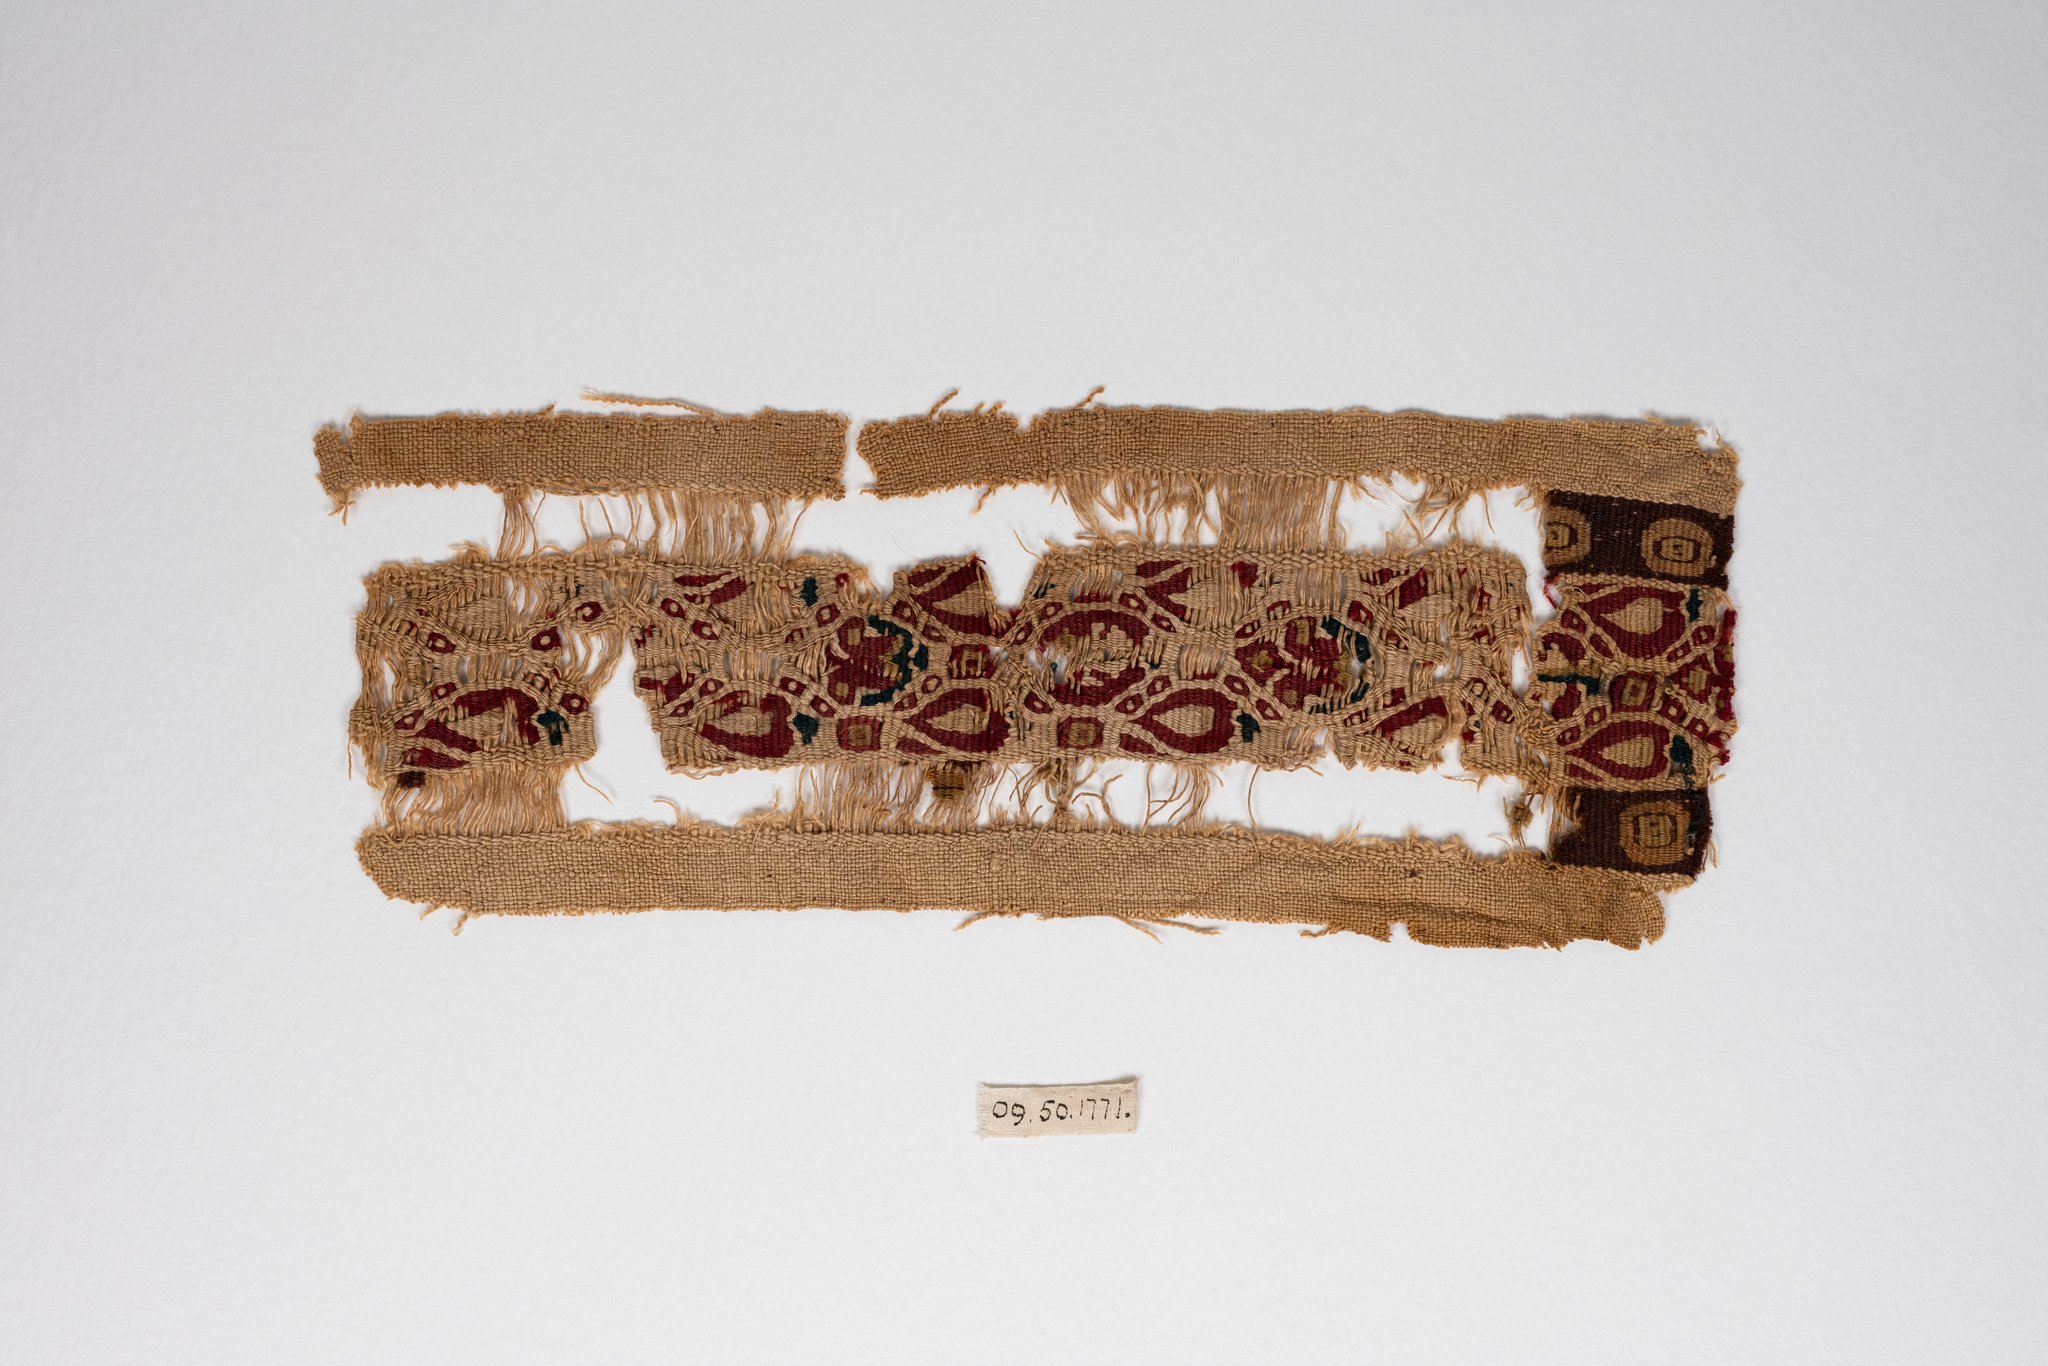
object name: band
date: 501-700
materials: linen, wool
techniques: weave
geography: egypt